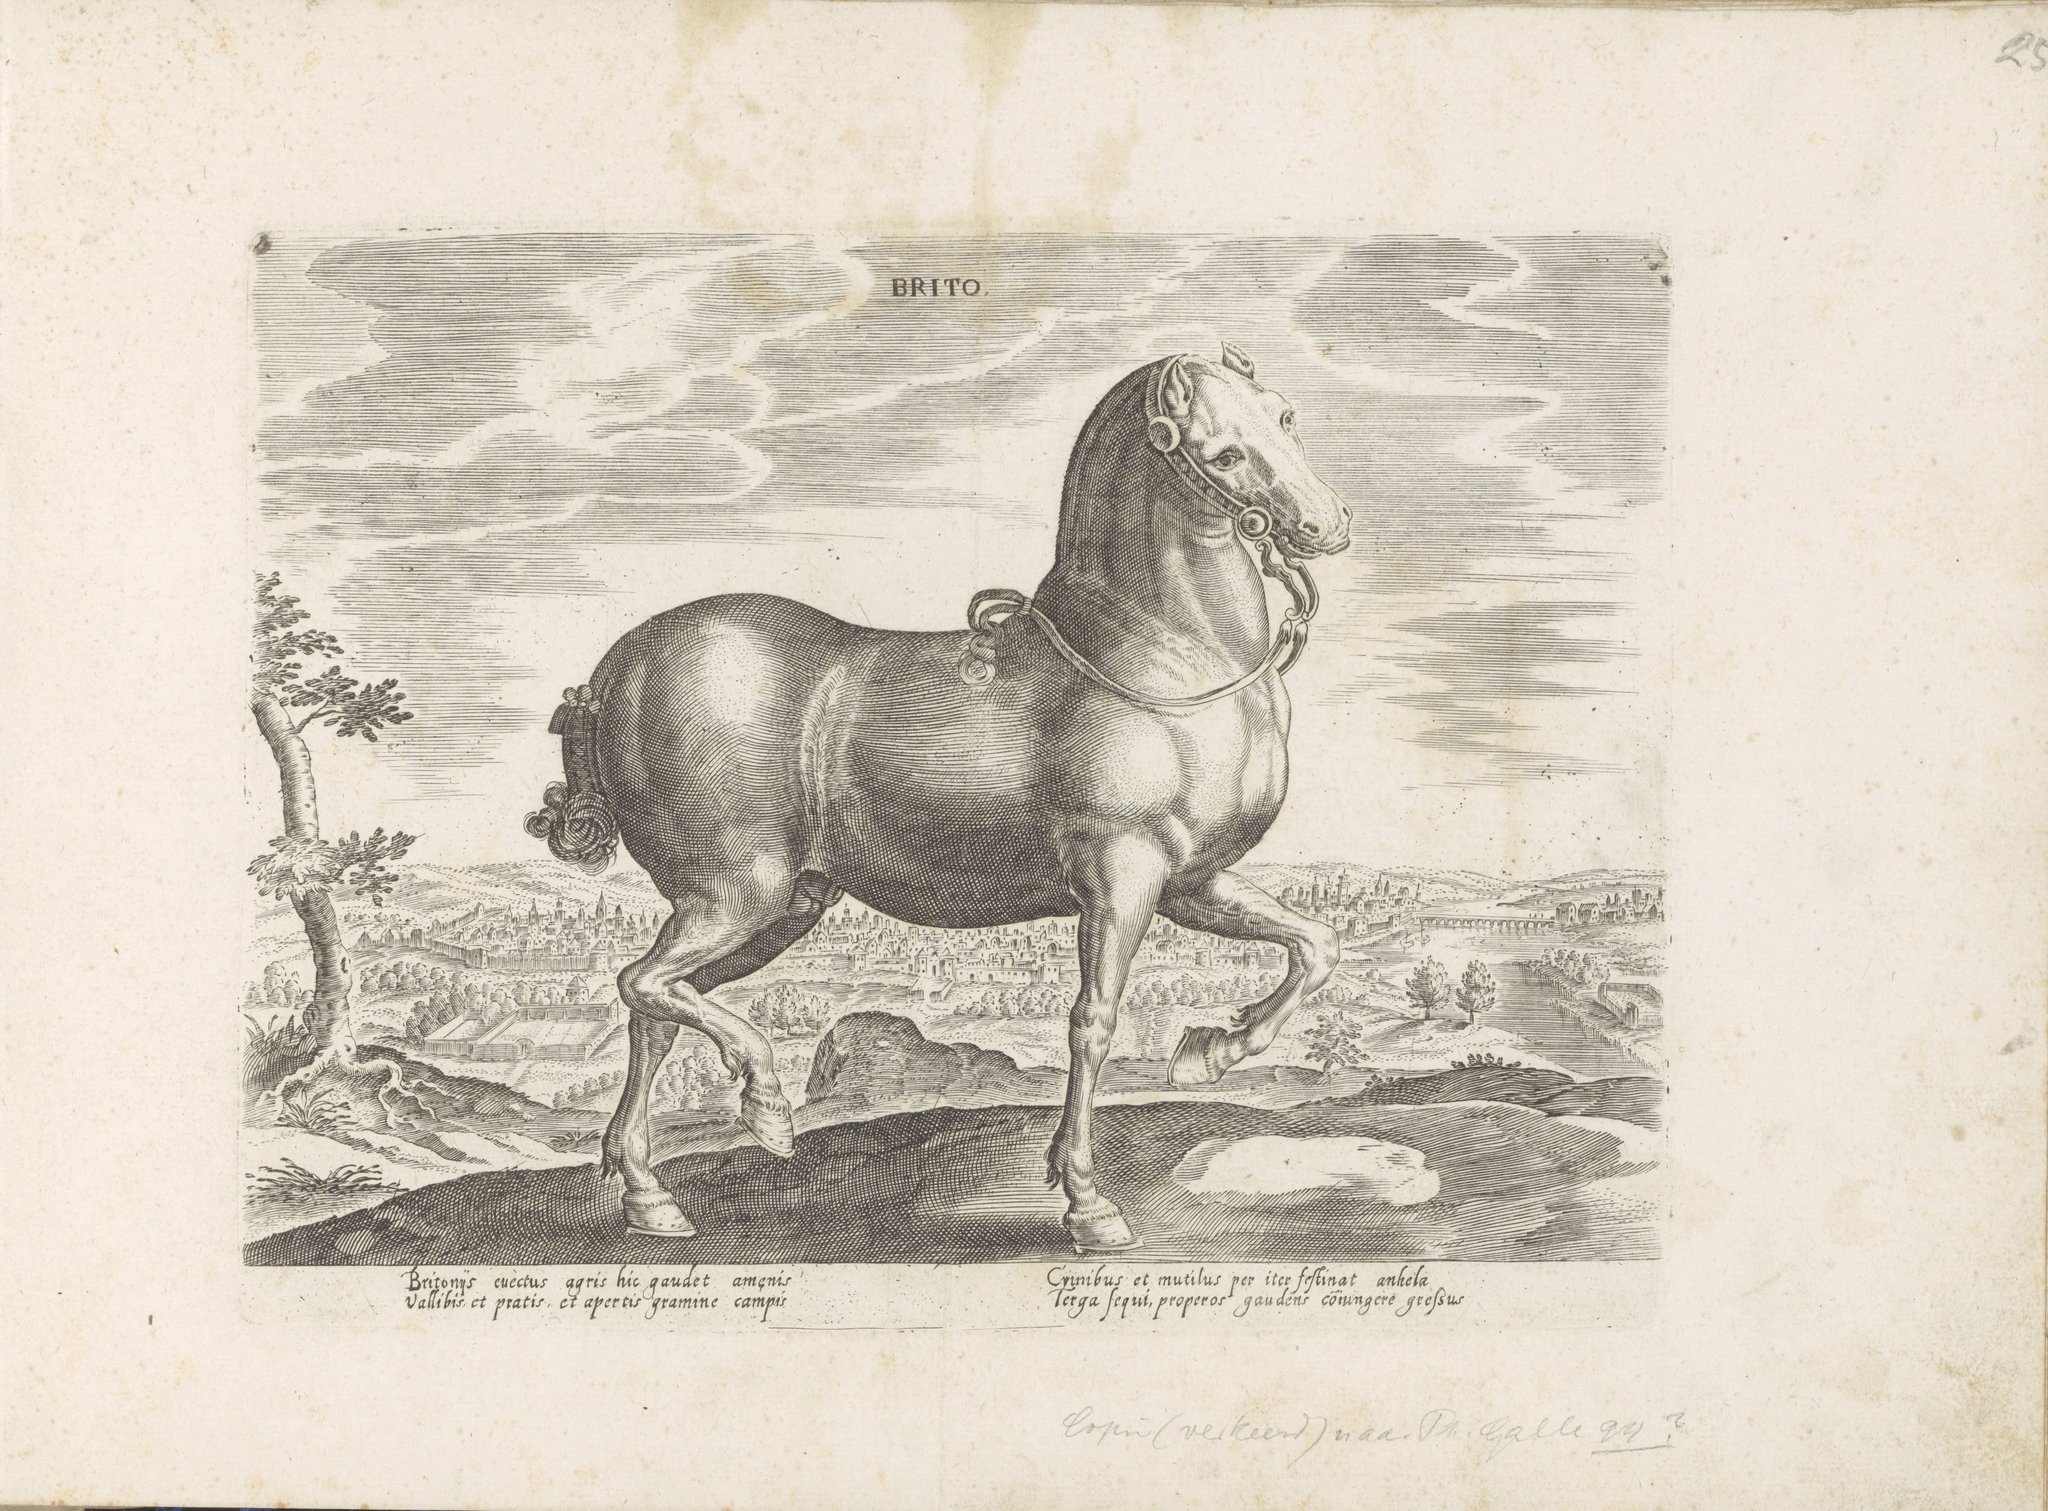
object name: print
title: Equile, in quo omnis generis generosissi: morum equorum ex varijs orbis partibus insignis delectus (...)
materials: paper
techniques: engraving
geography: venice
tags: don juan van oostenrijk, horses and kindred animals, england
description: Een Engels paard in een landschap. Prent maakt deel uit van een album.